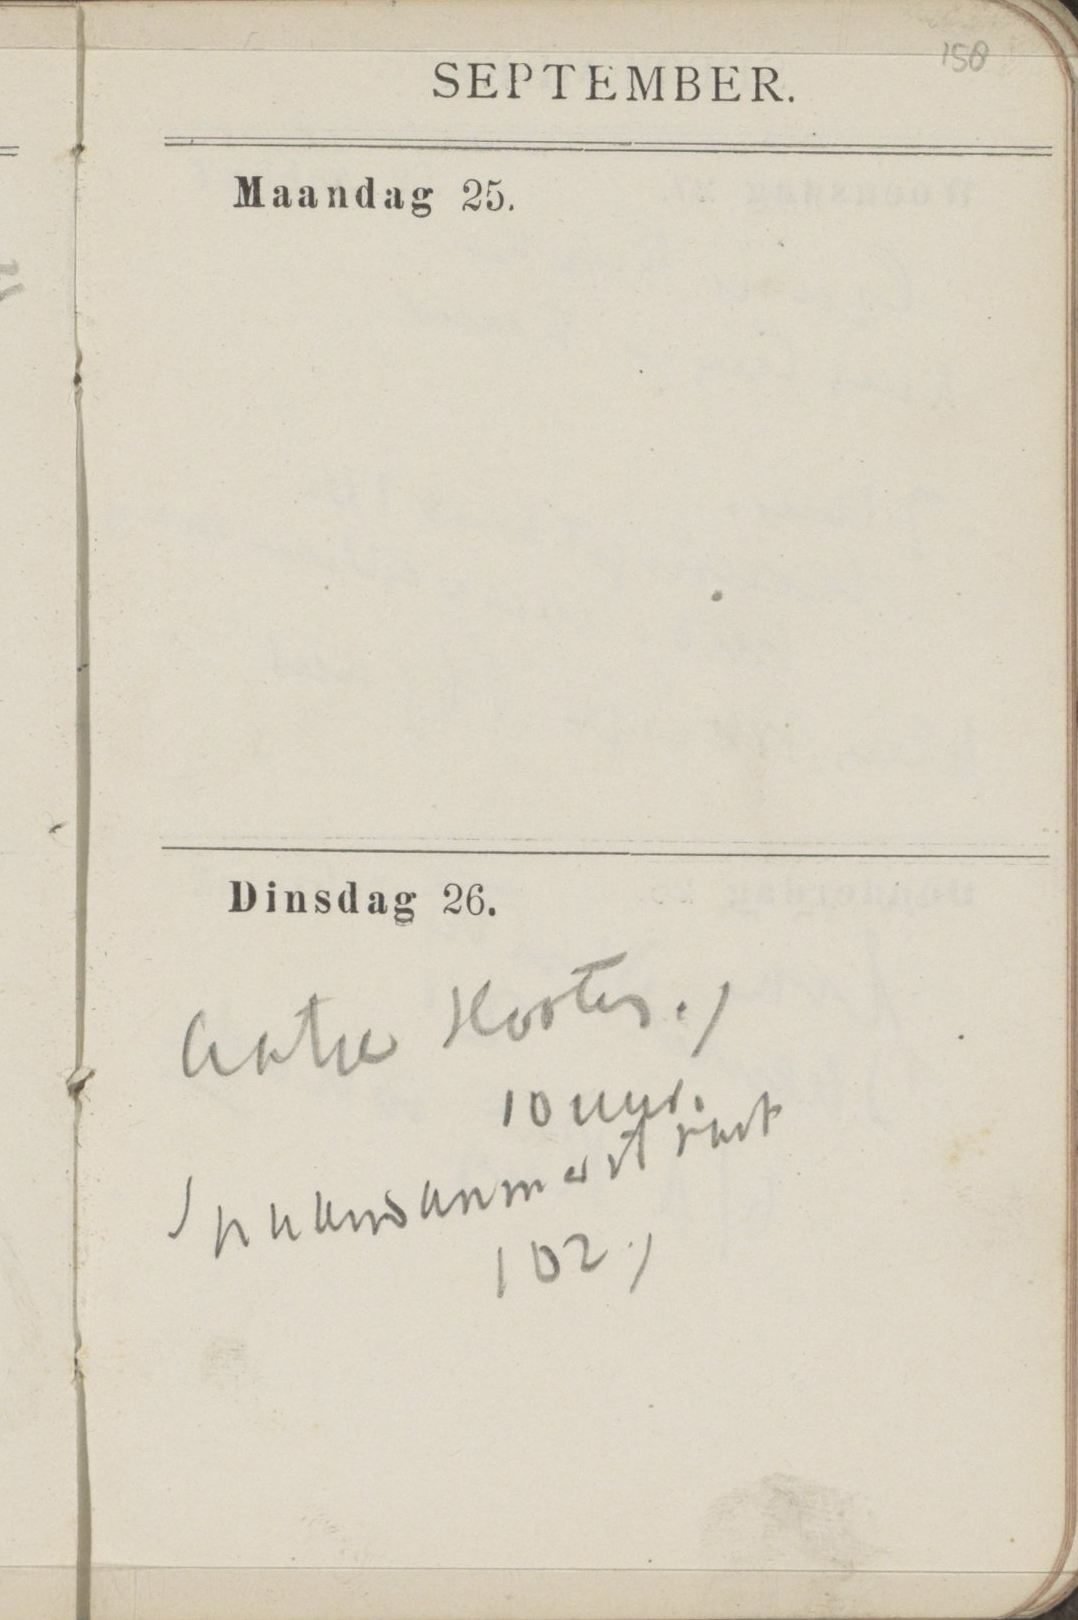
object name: sketchbook leaf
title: Annotaties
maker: george hendrik breitner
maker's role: draughtsman, painter, print maker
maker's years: 1857-1923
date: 1893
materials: paper, pencil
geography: amsterdam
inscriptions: annotation: ‘Antje Slooten.[?]/ 10 uur./ Spaarndammerstraat/ 102.’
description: Pagina 158 uit een als schetsboek gebruikte agenda met 108 bladen.